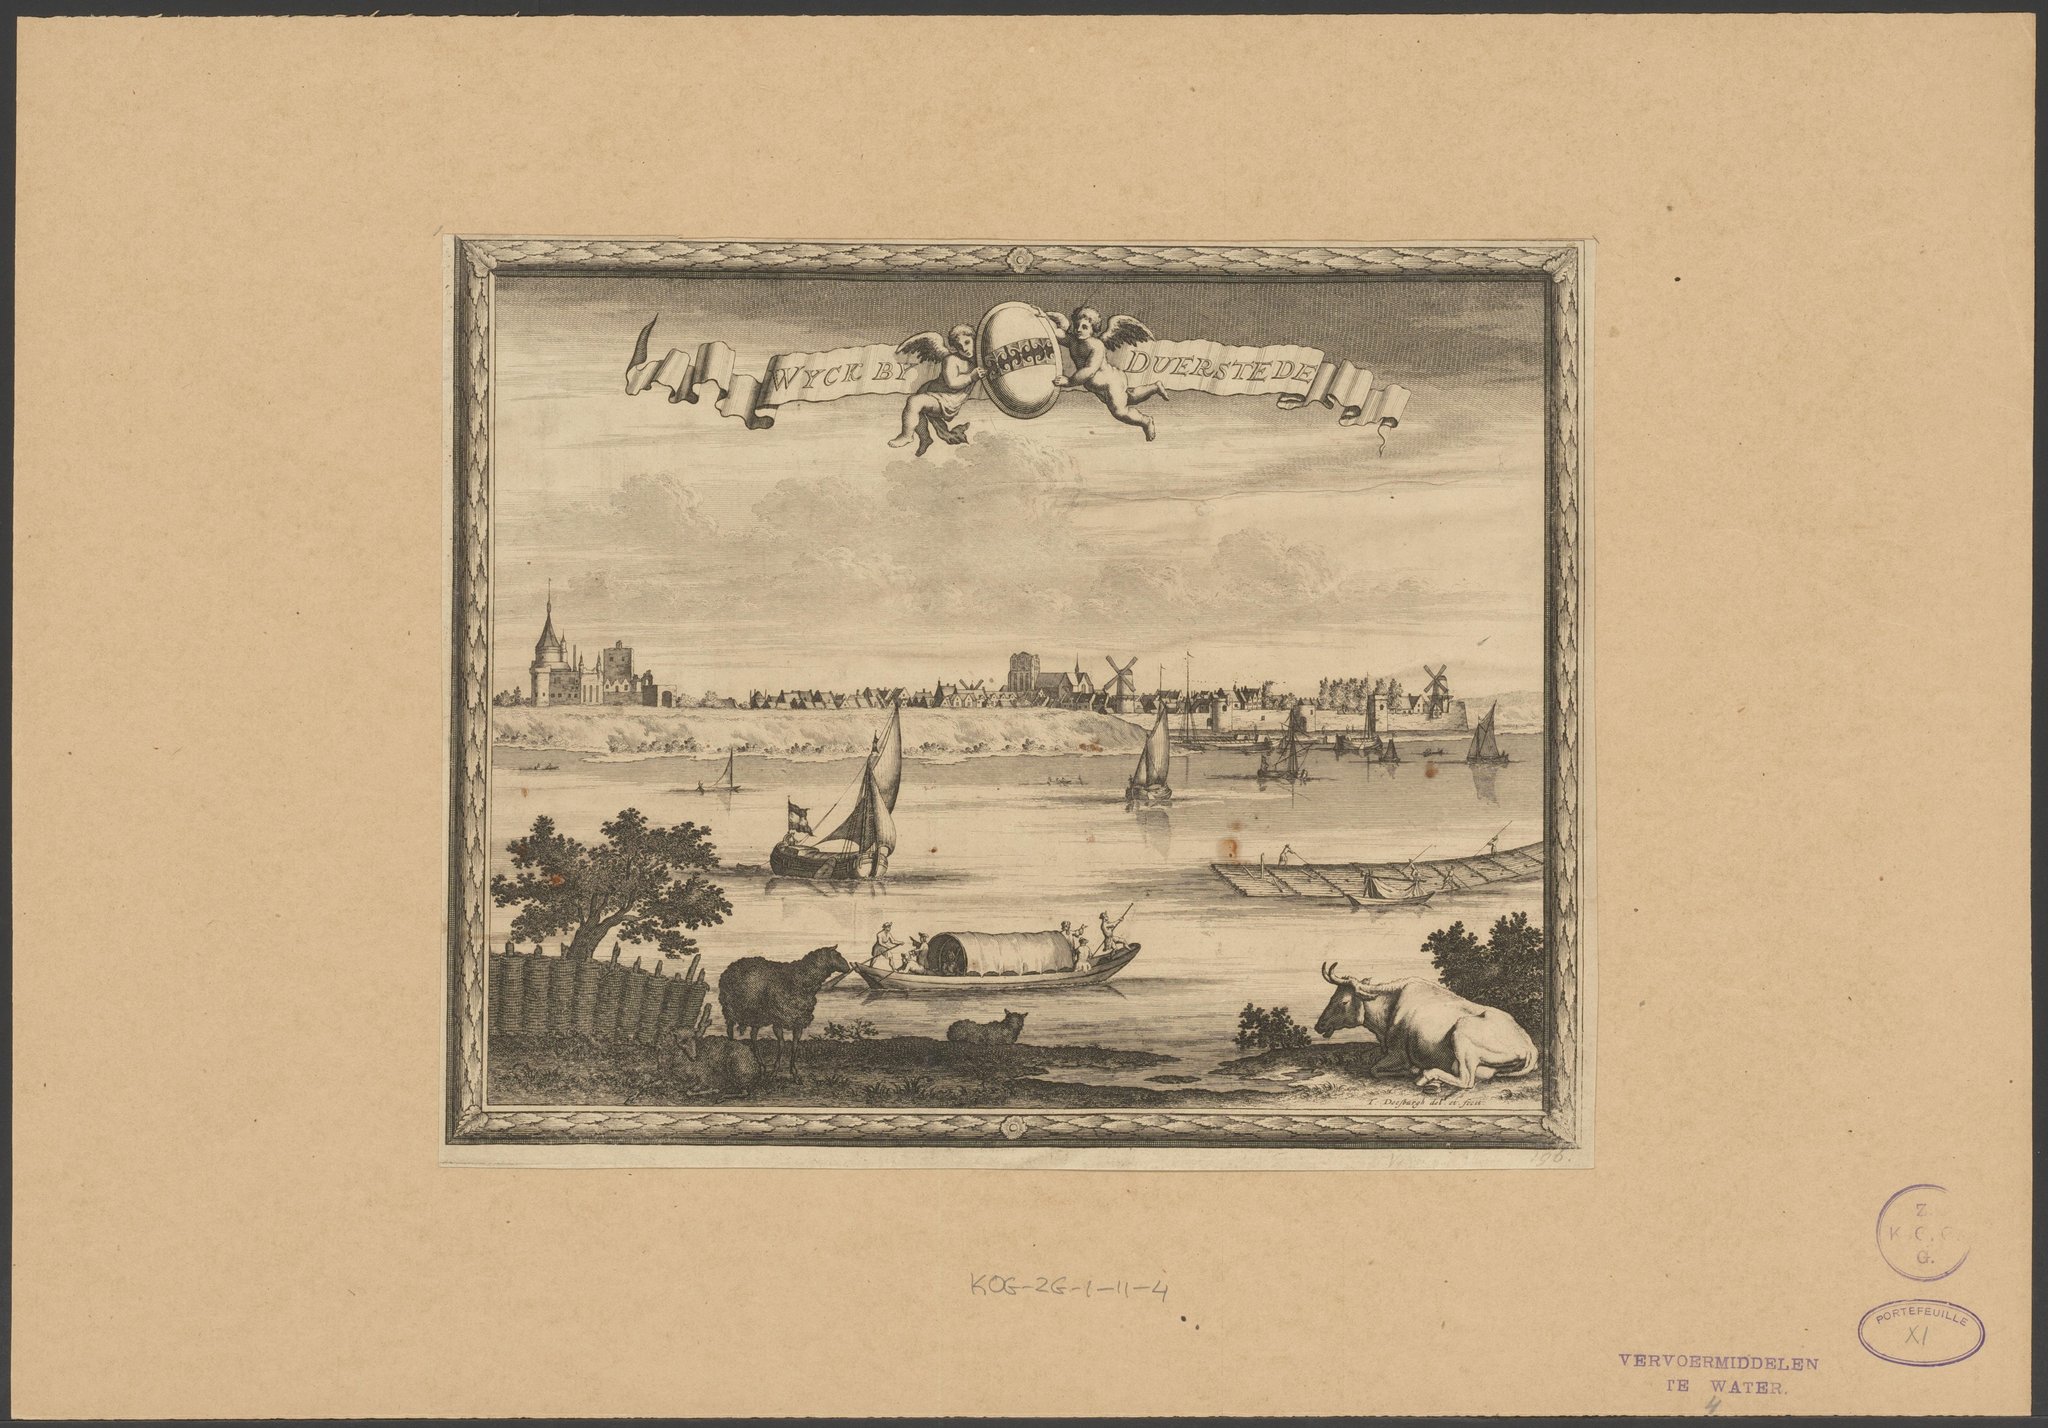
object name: print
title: Gezicht op Wijk bij Duurstede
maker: thomas doesburgh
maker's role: print maker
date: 1683-1714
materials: paper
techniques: etching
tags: sailing-ship, sailing-boat, city-view in general; 'veduta', landscape with tower or castle, poling, punting, church (exterior) - qq - small church, chapel, wijk bij duurstede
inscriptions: stamp, stamp, collector's mark: Lugt 1641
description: Op het water varen verschillende zeilschepen. In het midden vaart een roeiboot overdekt met een kap. Rechts een lang vlot. Onderwerpsrubrieken binnen de Atlas Zeden en Gewoonten: Handel, nijverheid en verkeer, Vervoermiddelen te land en te water, Vervoermiddelen te water.